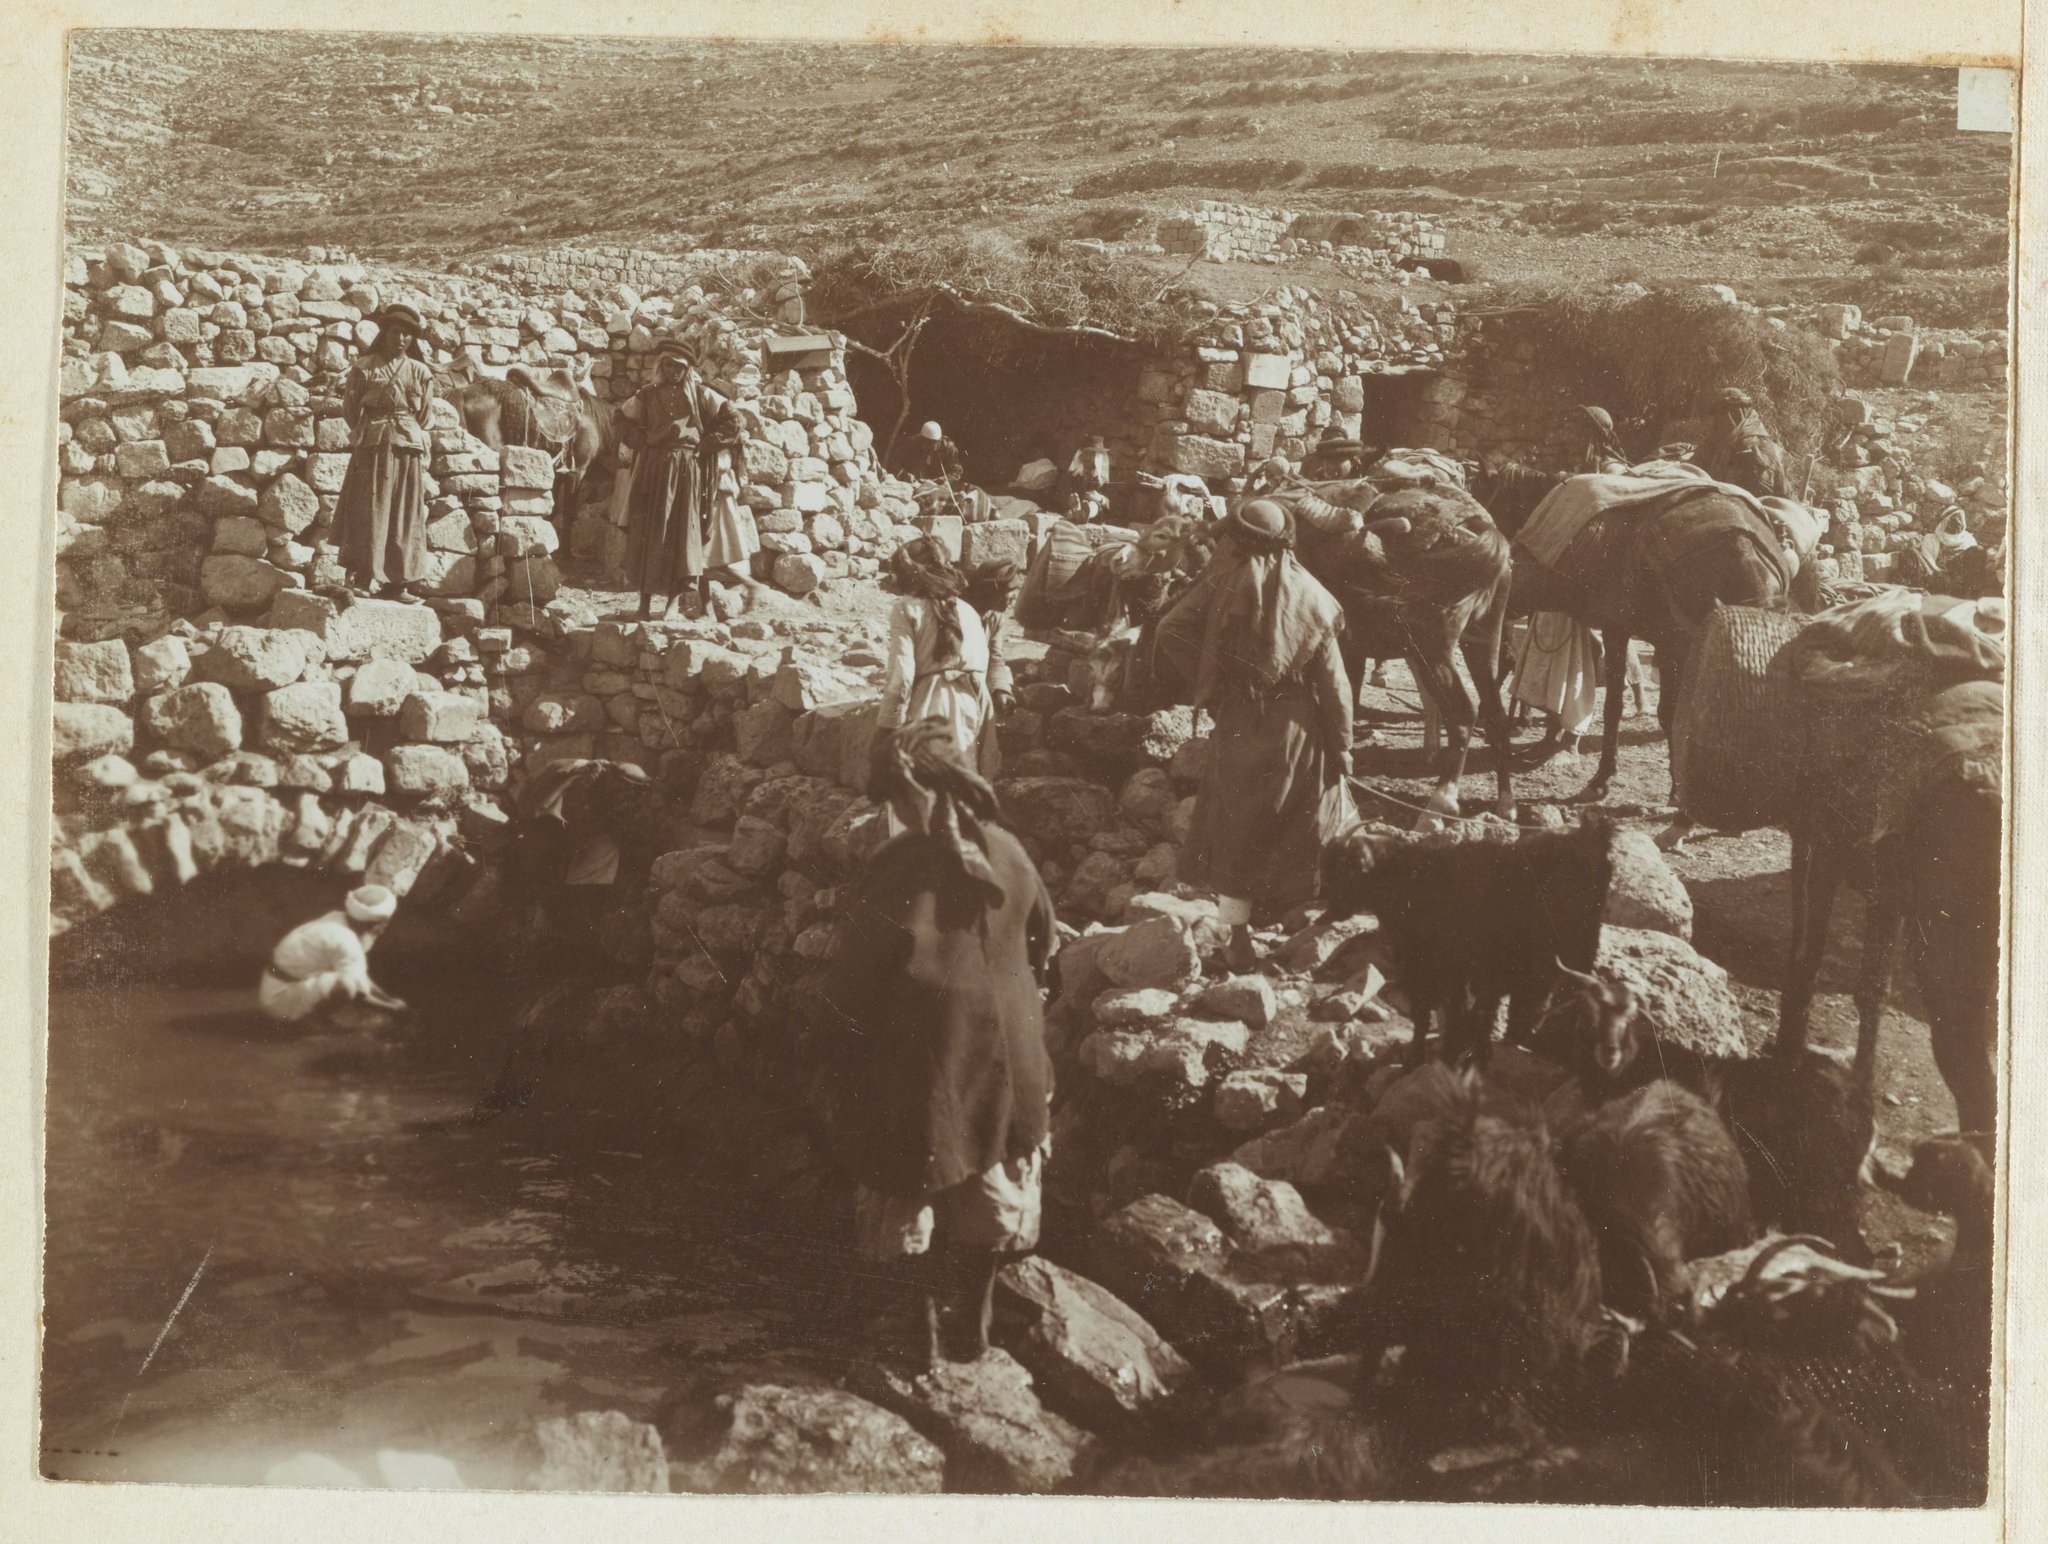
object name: photograph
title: Mensen en dieren bij de waterbron bij Al-Lubban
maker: johannes lodewijk heldring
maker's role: fotograaf, predikant, schrijver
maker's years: 1852-1923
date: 1898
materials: paper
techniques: collodion silver print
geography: west bank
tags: well